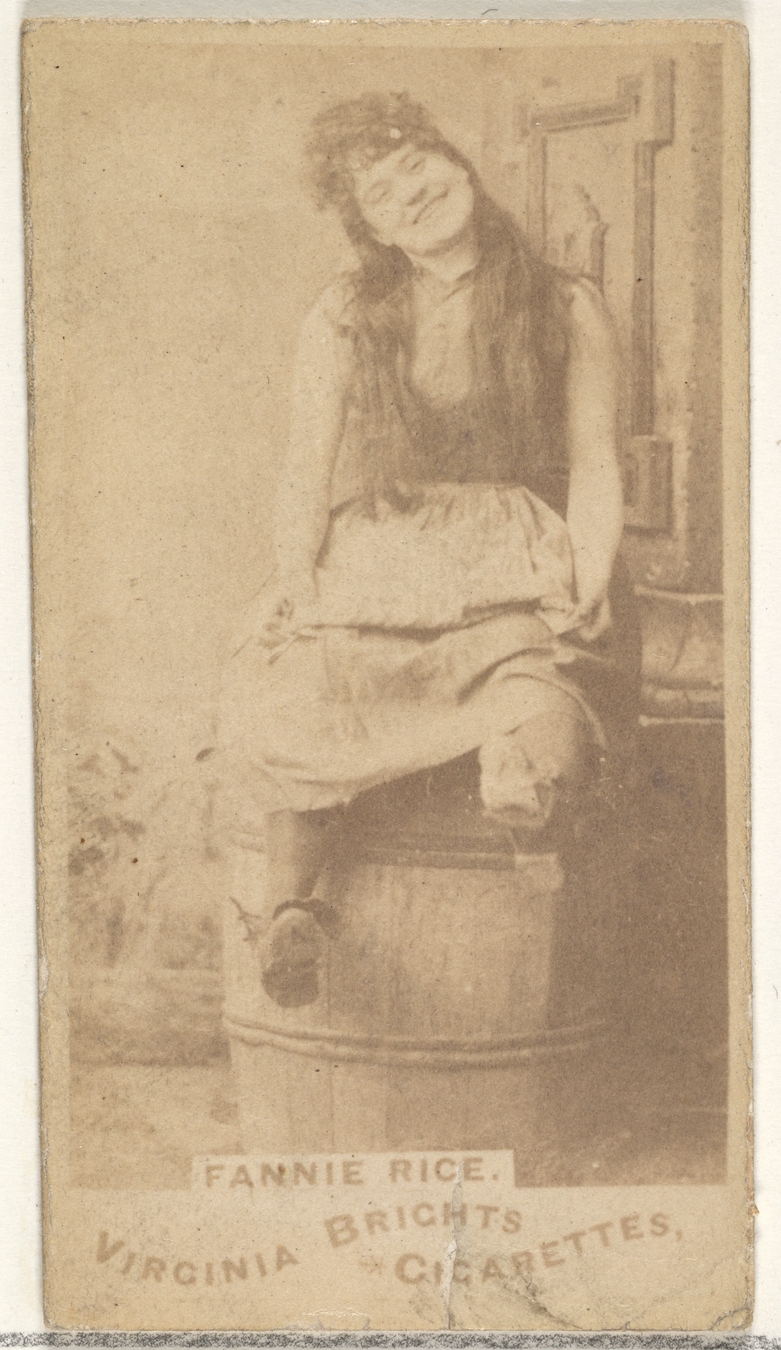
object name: photograph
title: Fanny Rice, from the Actors and Actresses series (N45, Type 1) for Virginia Brights Cigarettes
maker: allen & ginter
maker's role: publisher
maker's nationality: american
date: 1888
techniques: albumen silver print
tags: portraits,women,actresses